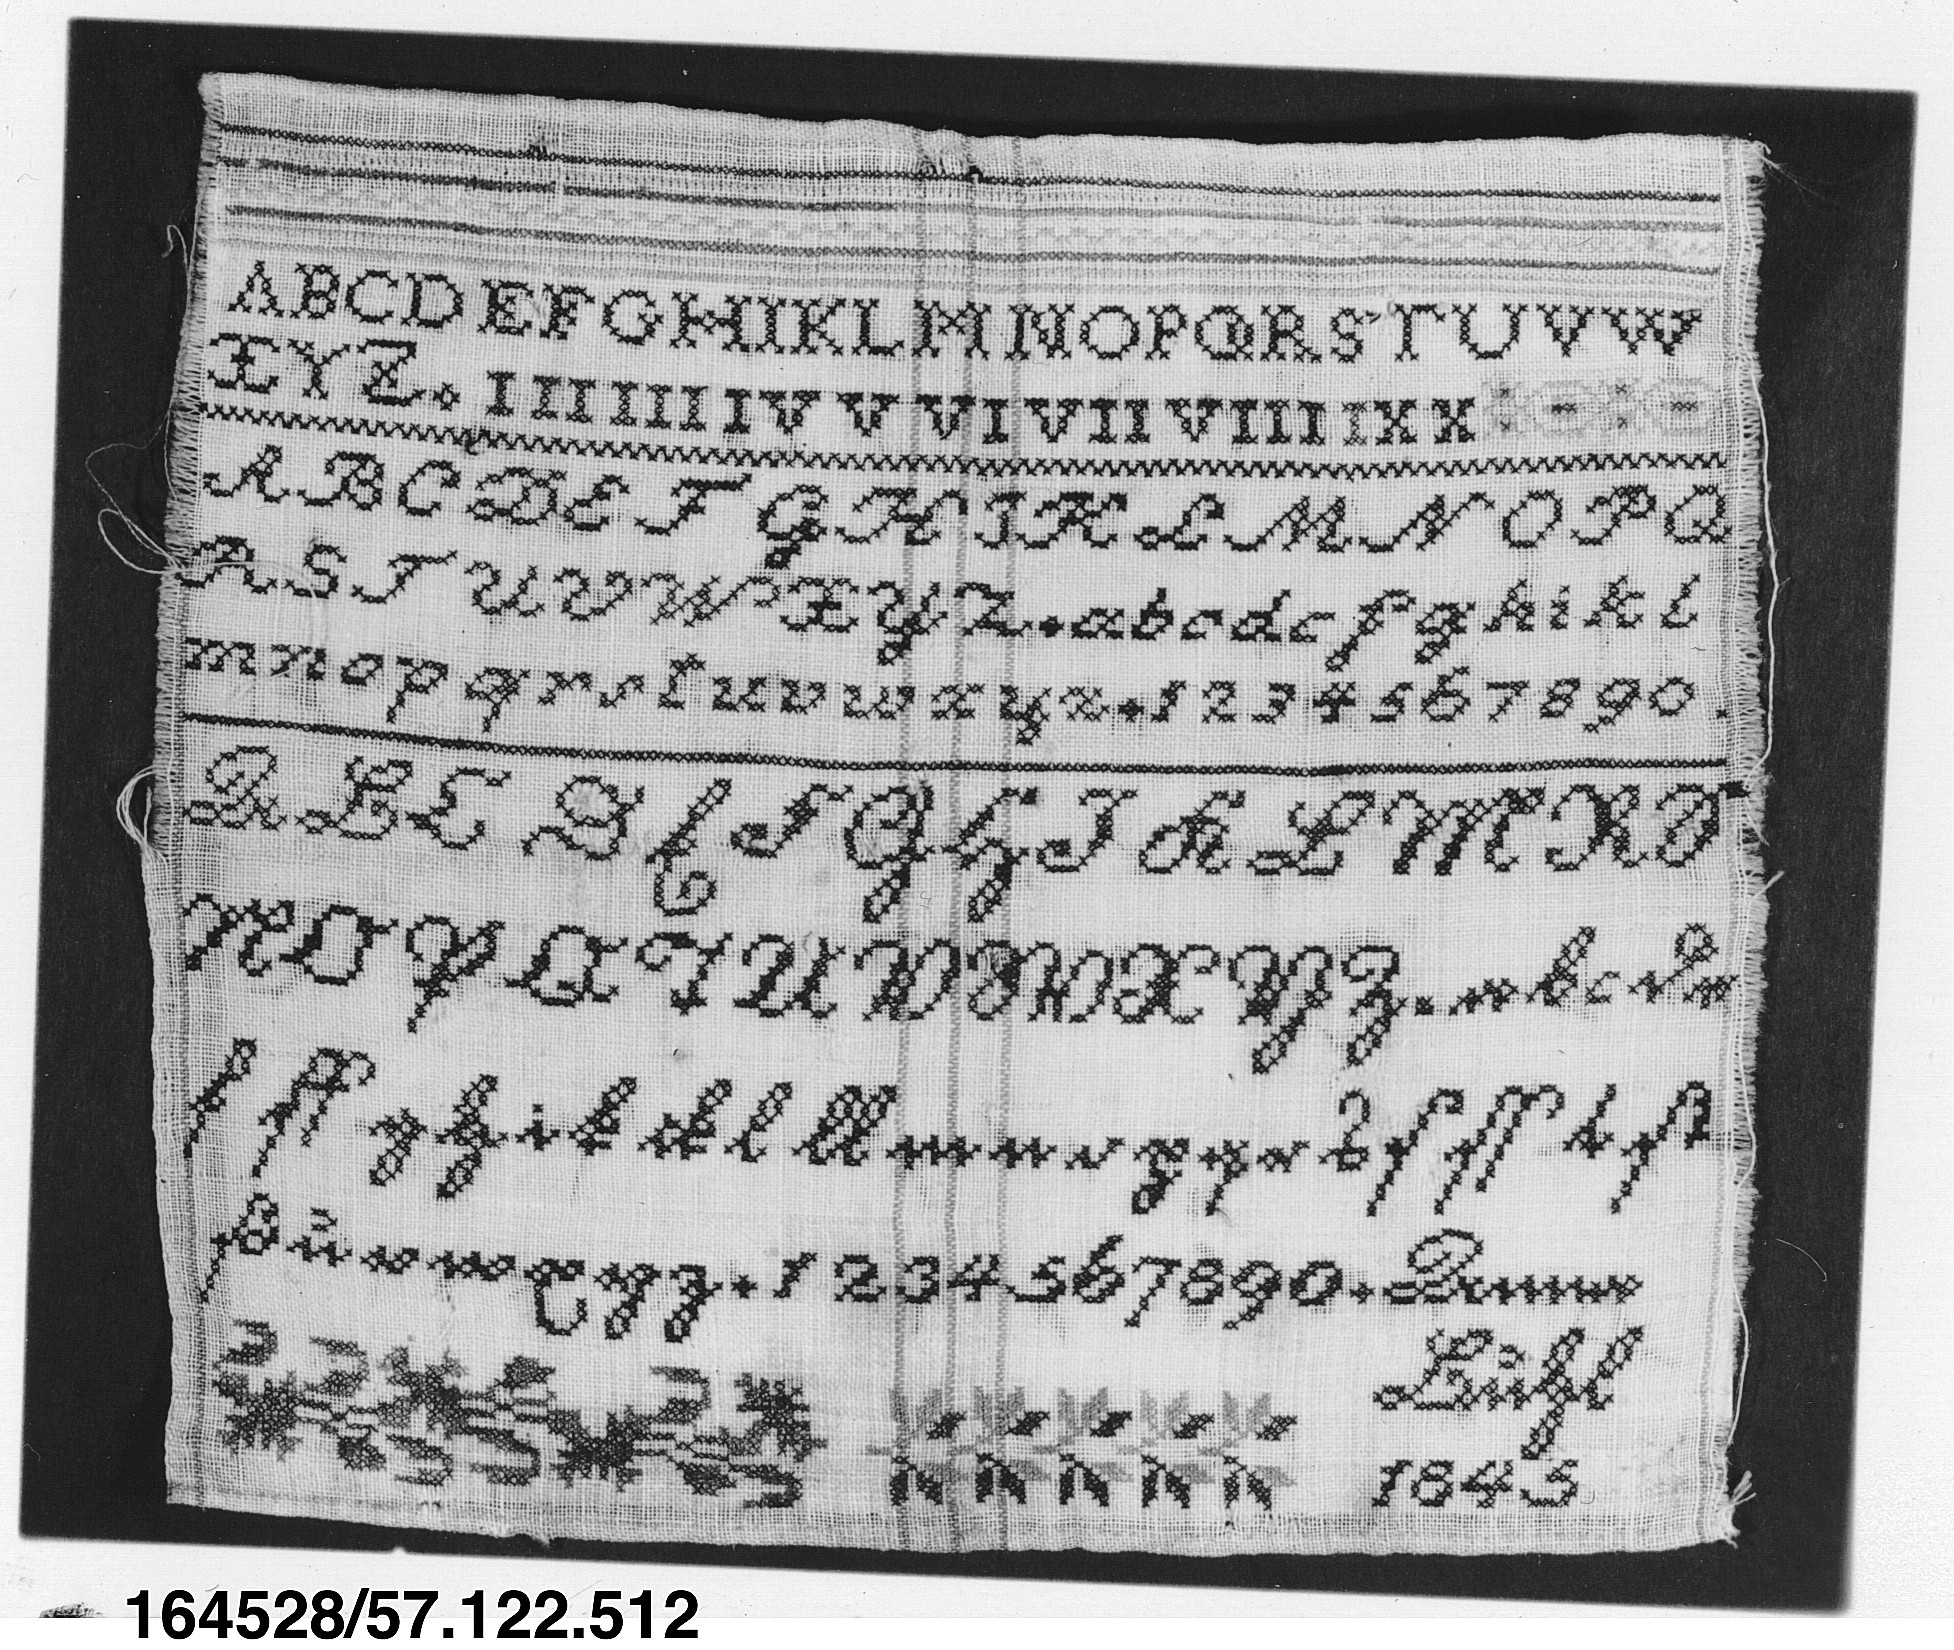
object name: sampler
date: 1845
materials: canvas, silk, wool